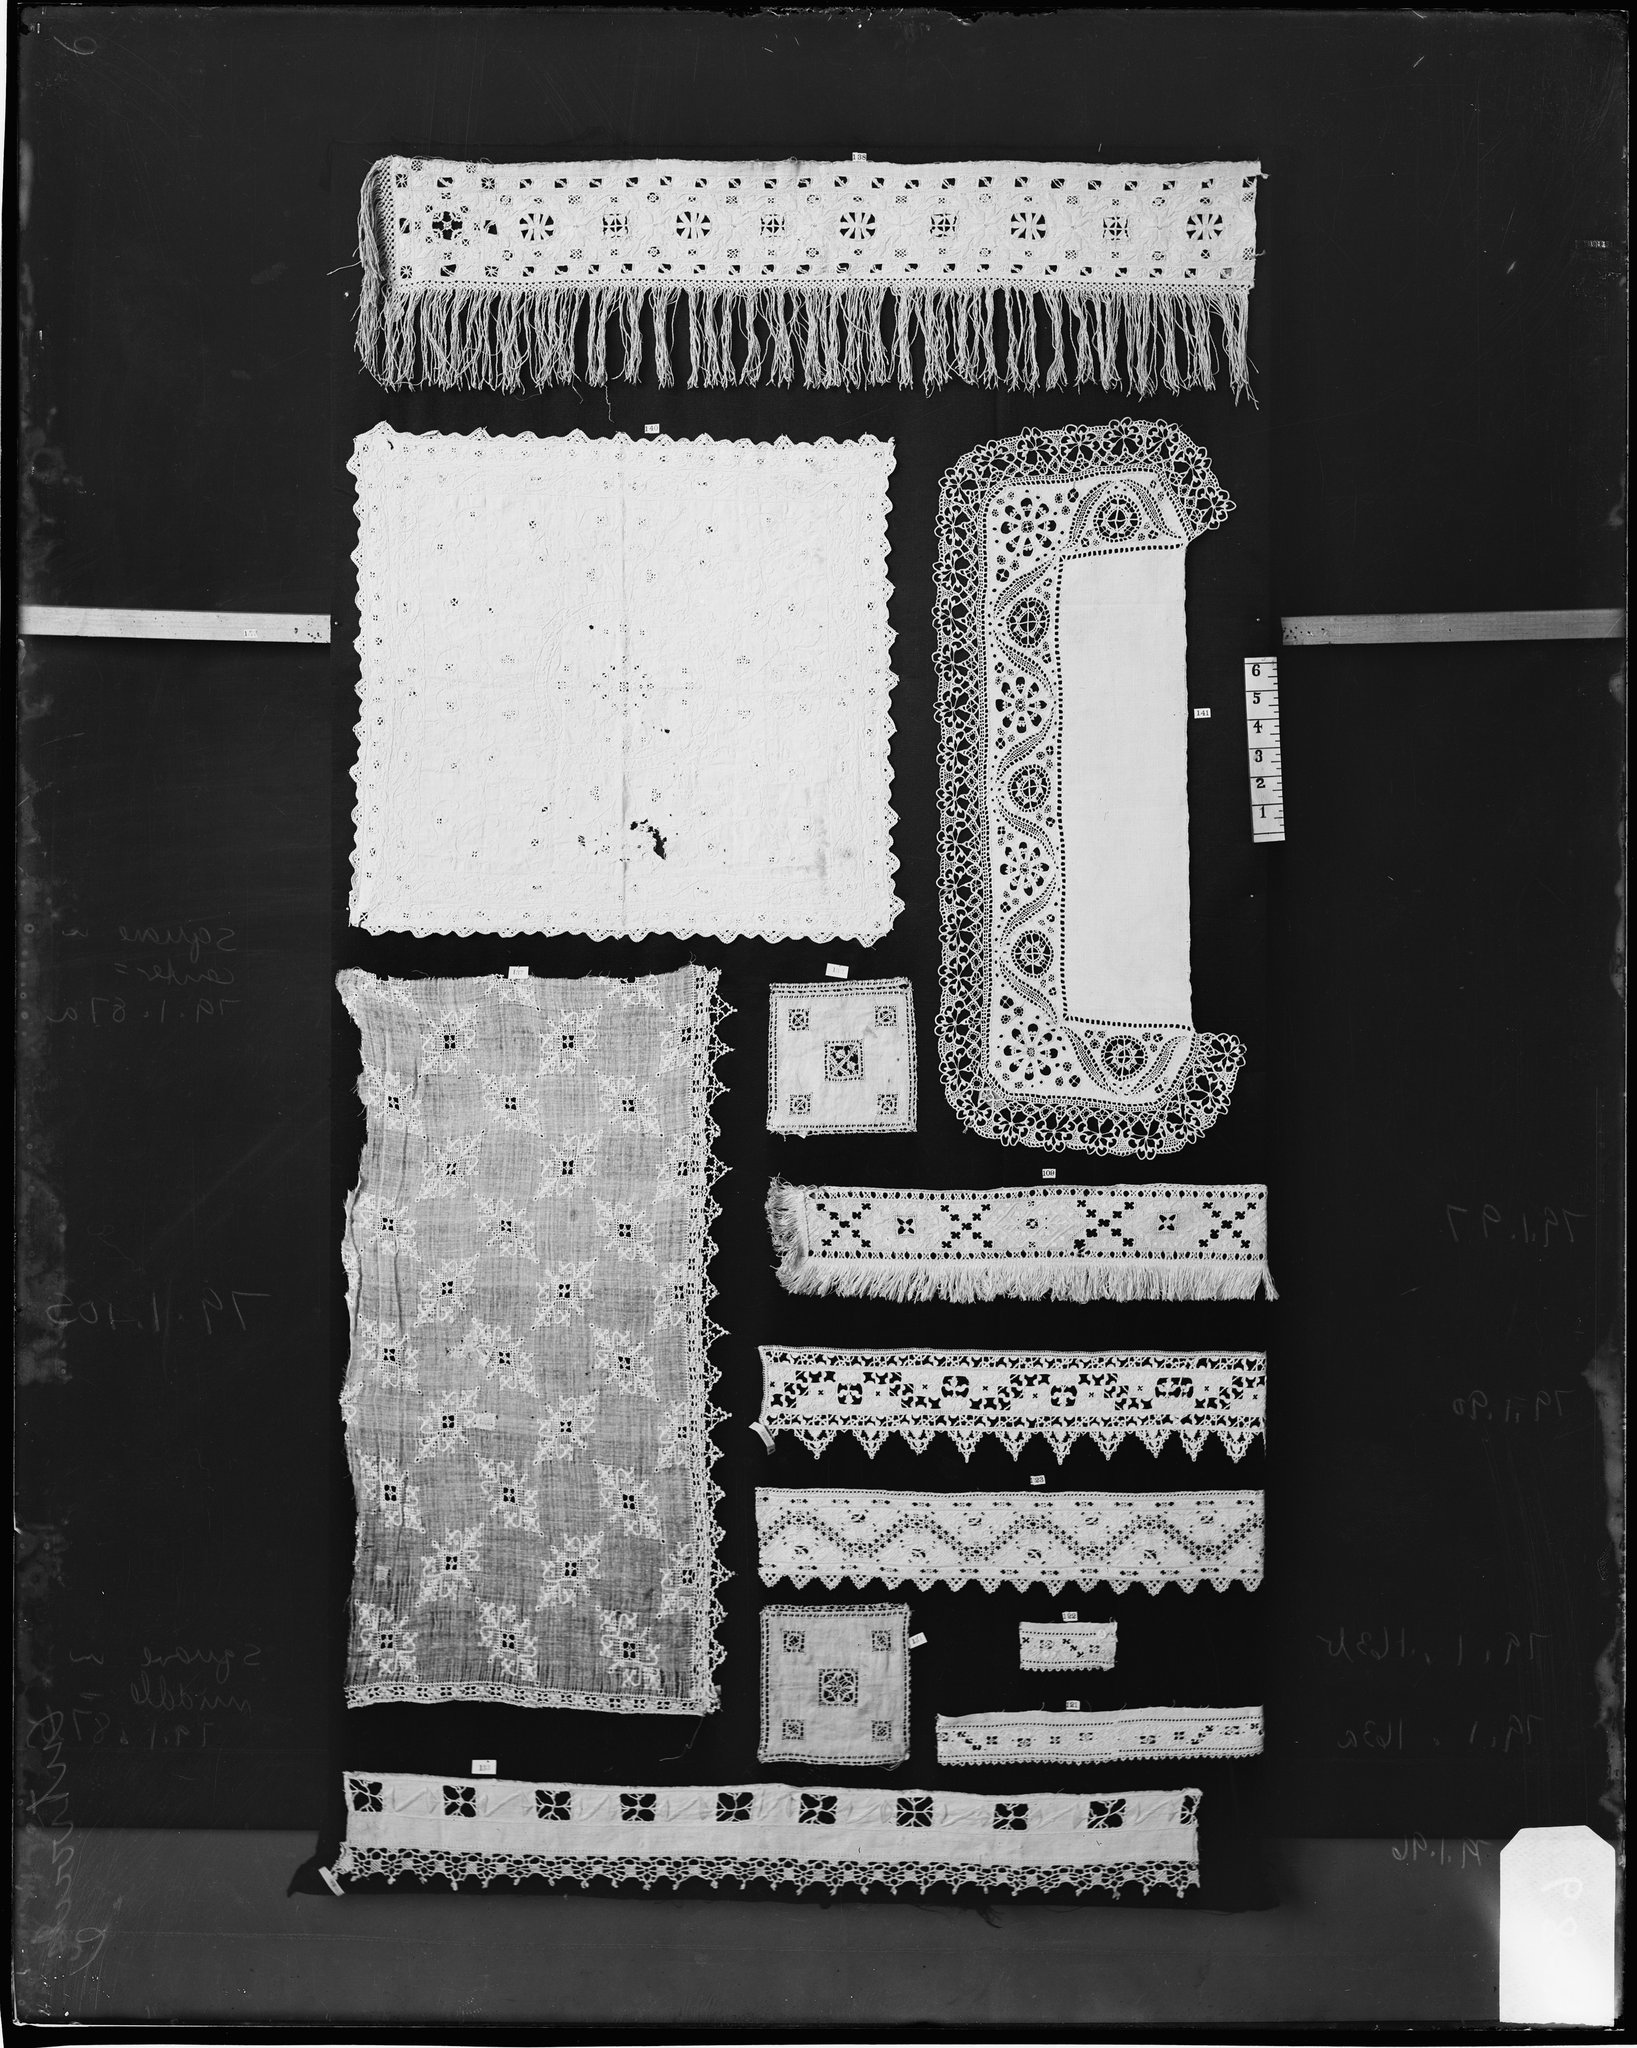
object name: square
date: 1600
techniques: embroidery